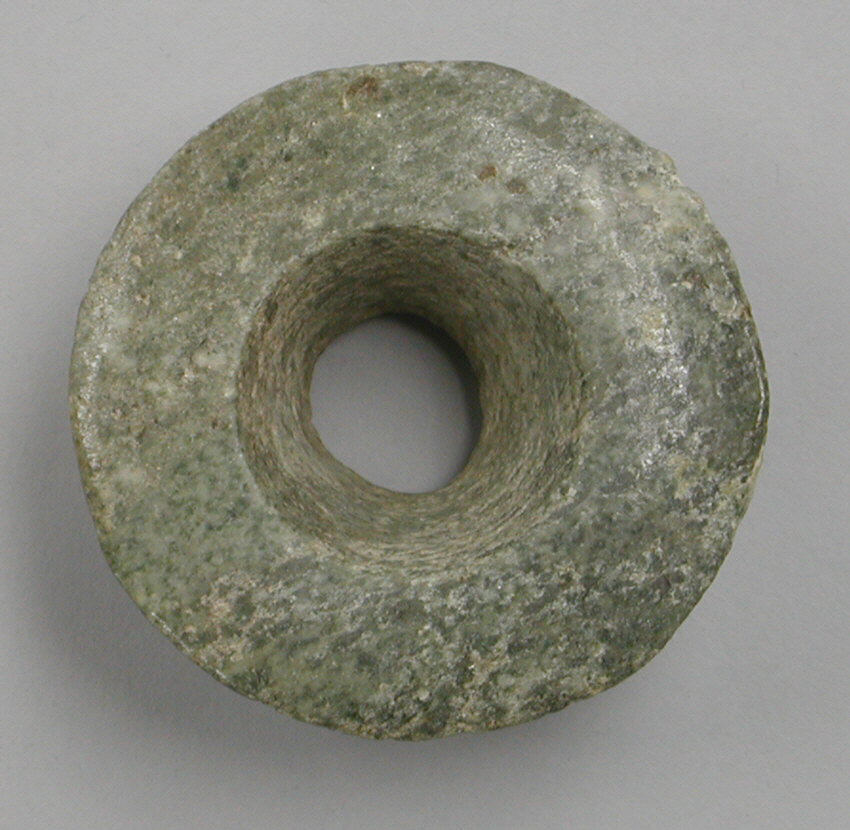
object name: earflare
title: Stone Earflare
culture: mexican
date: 1501-1600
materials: stone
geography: mexico